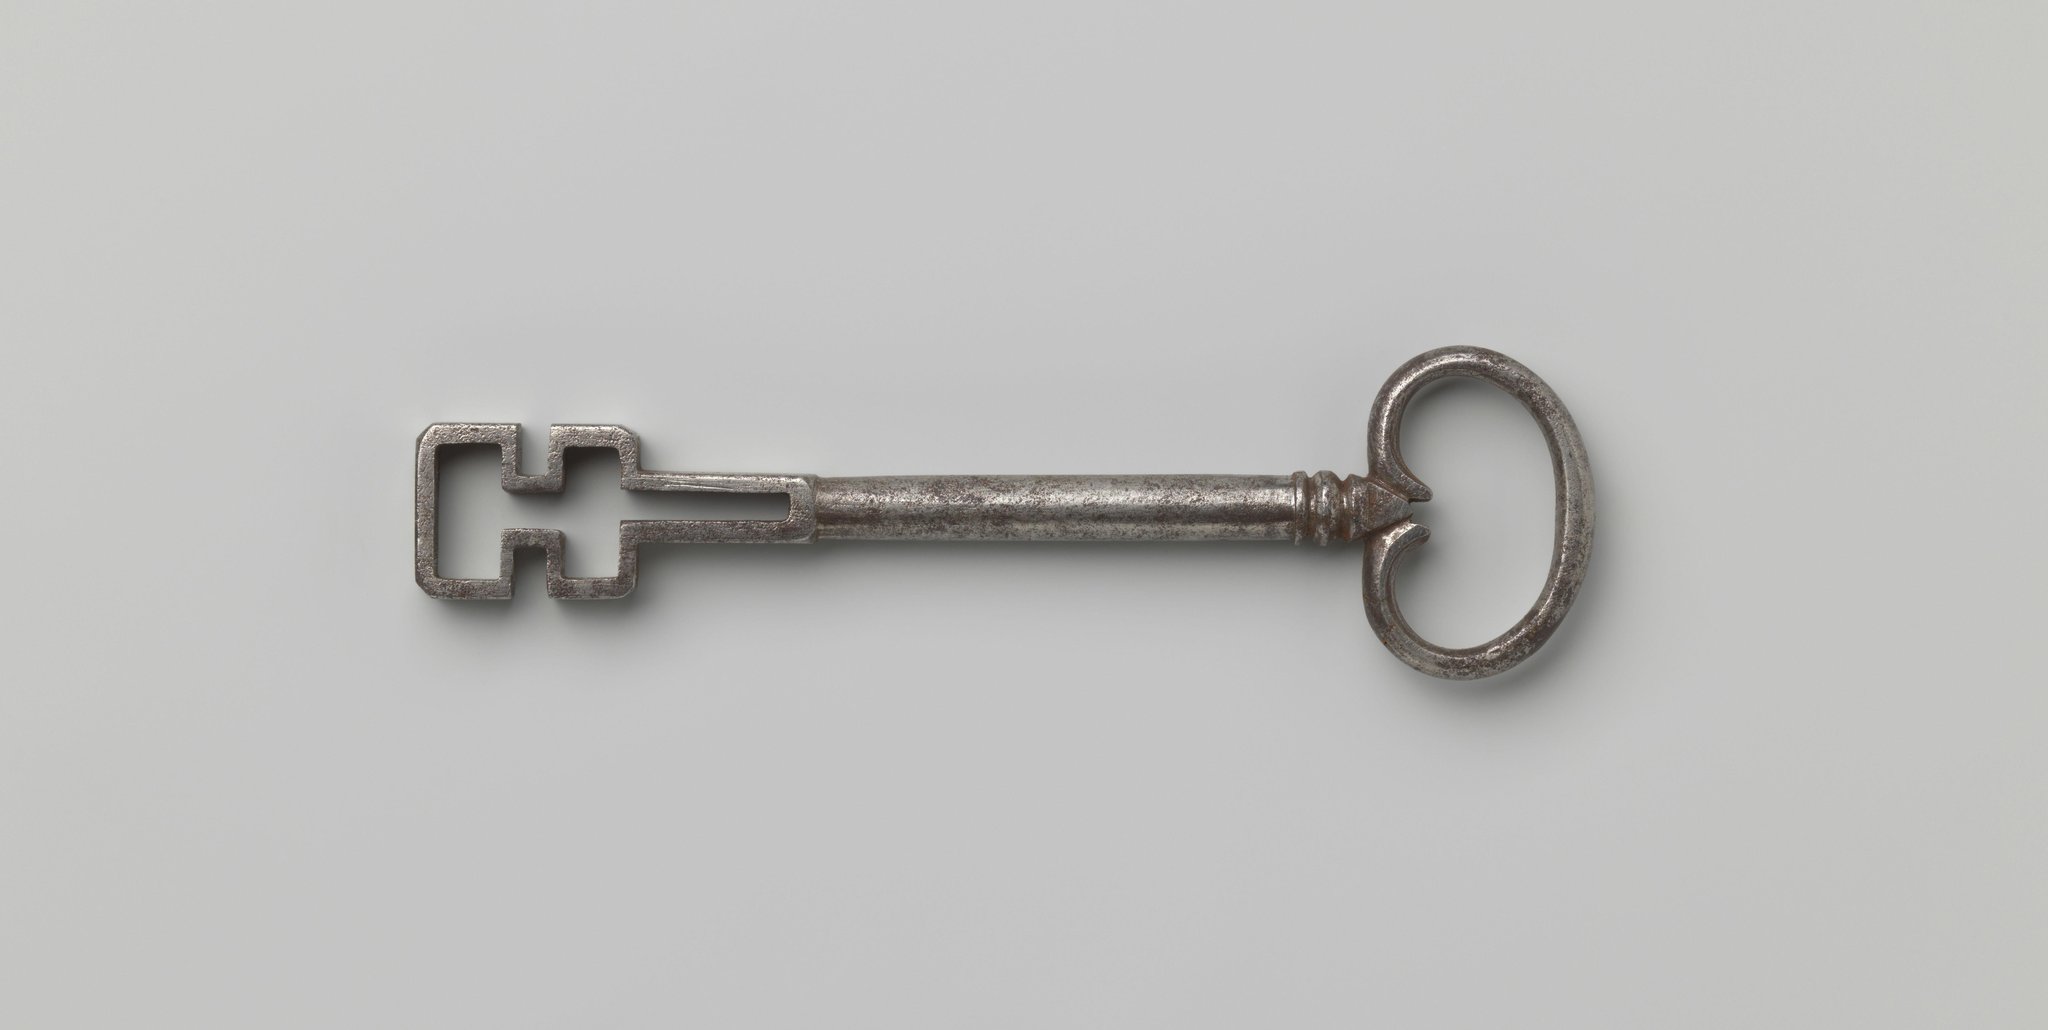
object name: key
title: Sleutel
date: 1400-1950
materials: iron